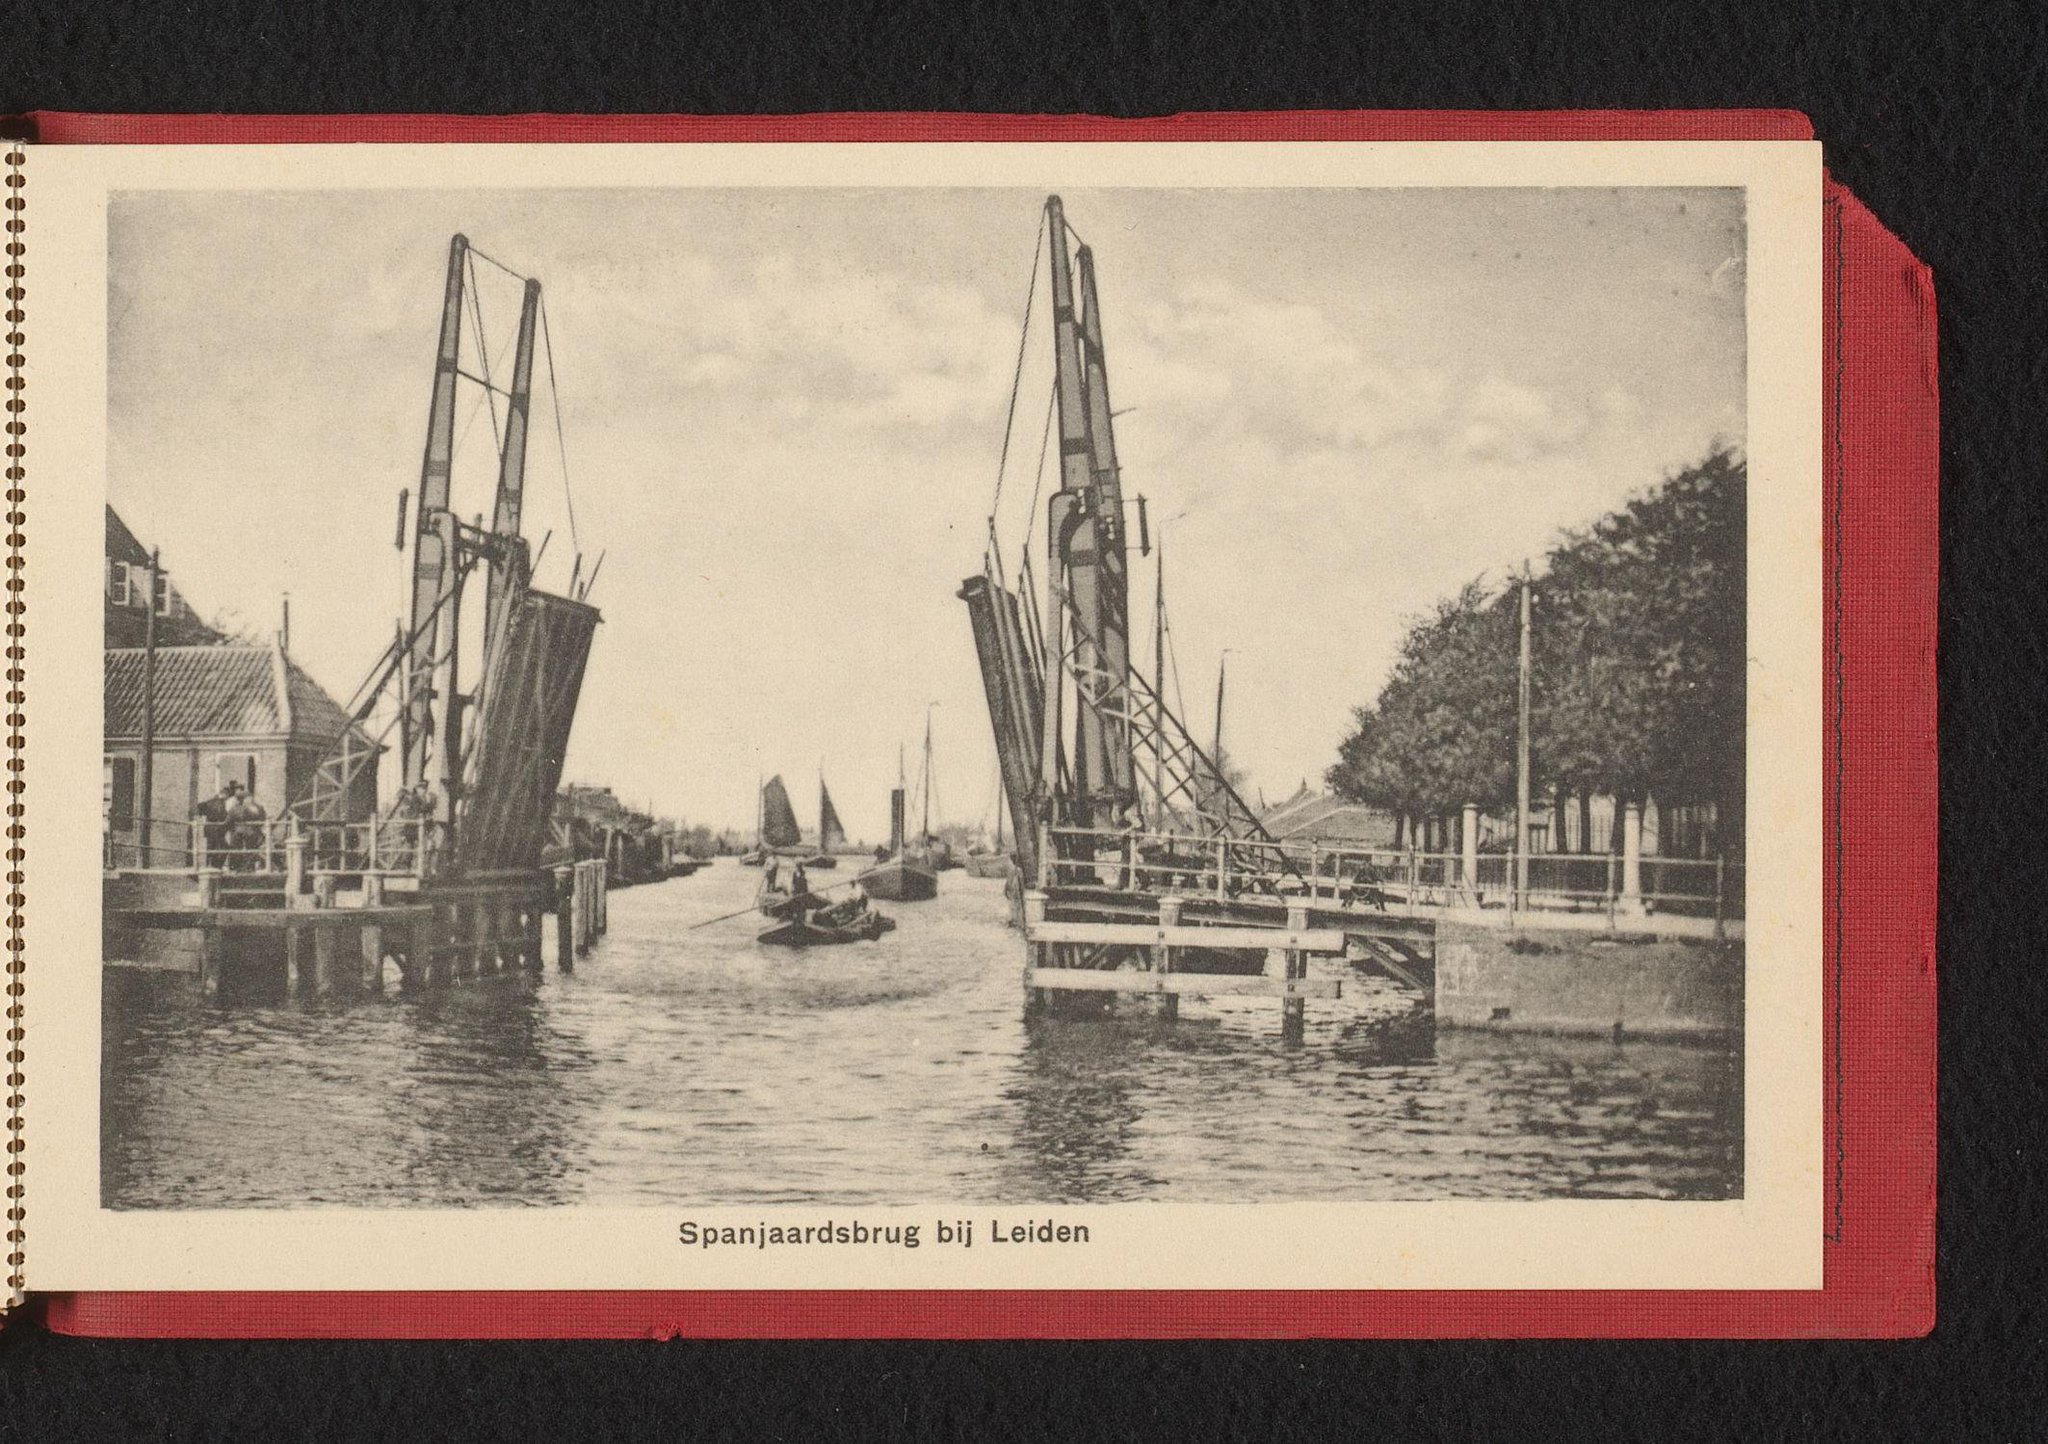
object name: photomechanical print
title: Spanjaardsbrug bij Leiden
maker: Anonymous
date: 1906-1915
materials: cardboard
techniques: photograph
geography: amsterdam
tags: river, ships (in general), bridge in city across river, canal, etc., leiden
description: Prentbriefkaart maakt deel uit van een album.